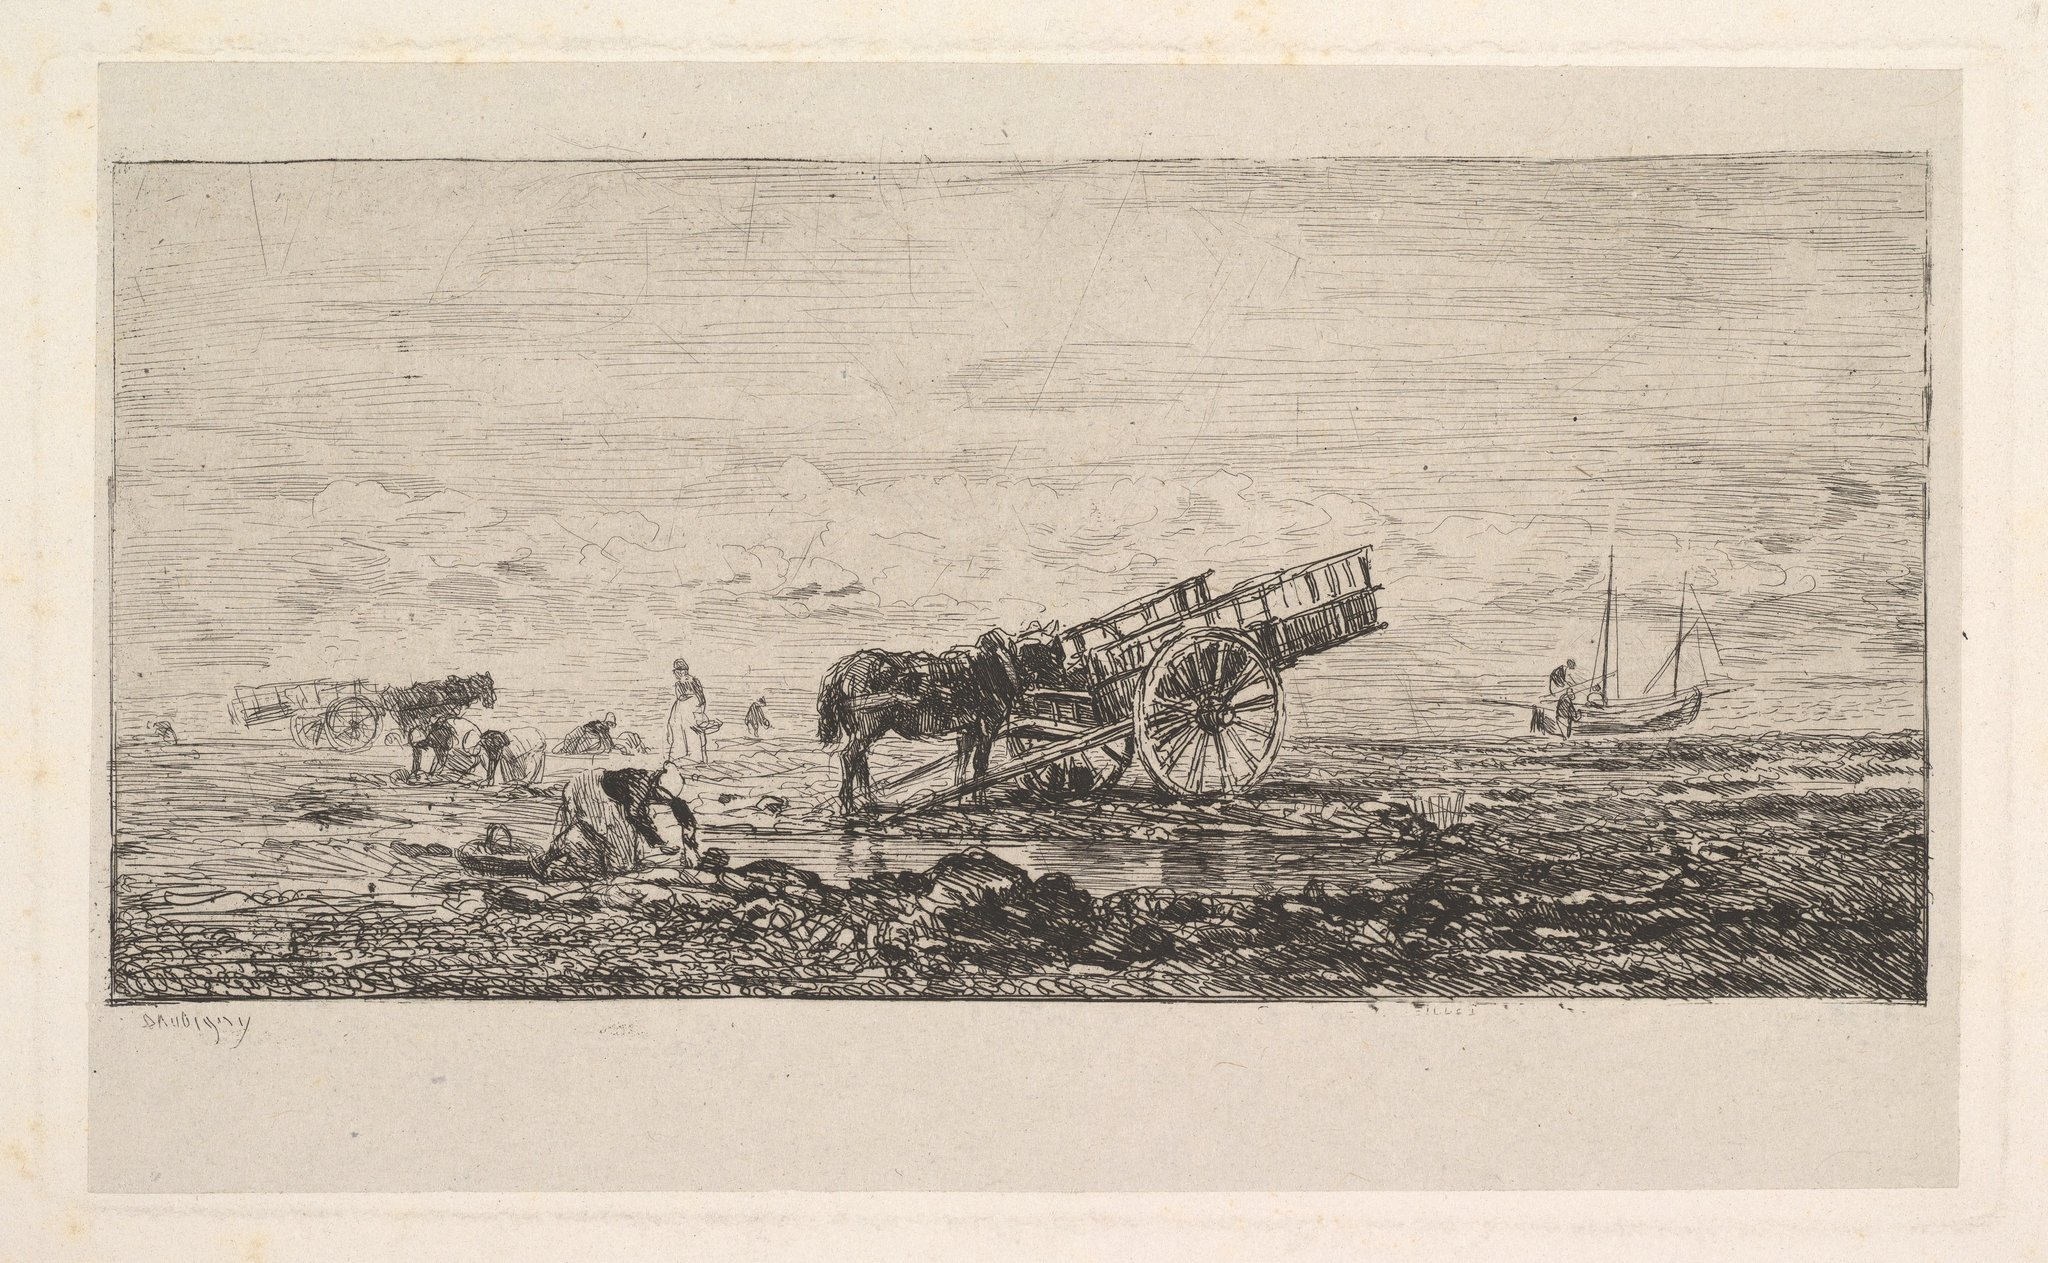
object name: print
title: The Beach at Villerville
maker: charles-françois daubigny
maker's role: artist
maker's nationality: french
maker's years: 1817-1878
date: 1837-1878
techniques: printmaking, etching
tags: horses,beaches,boats,carts